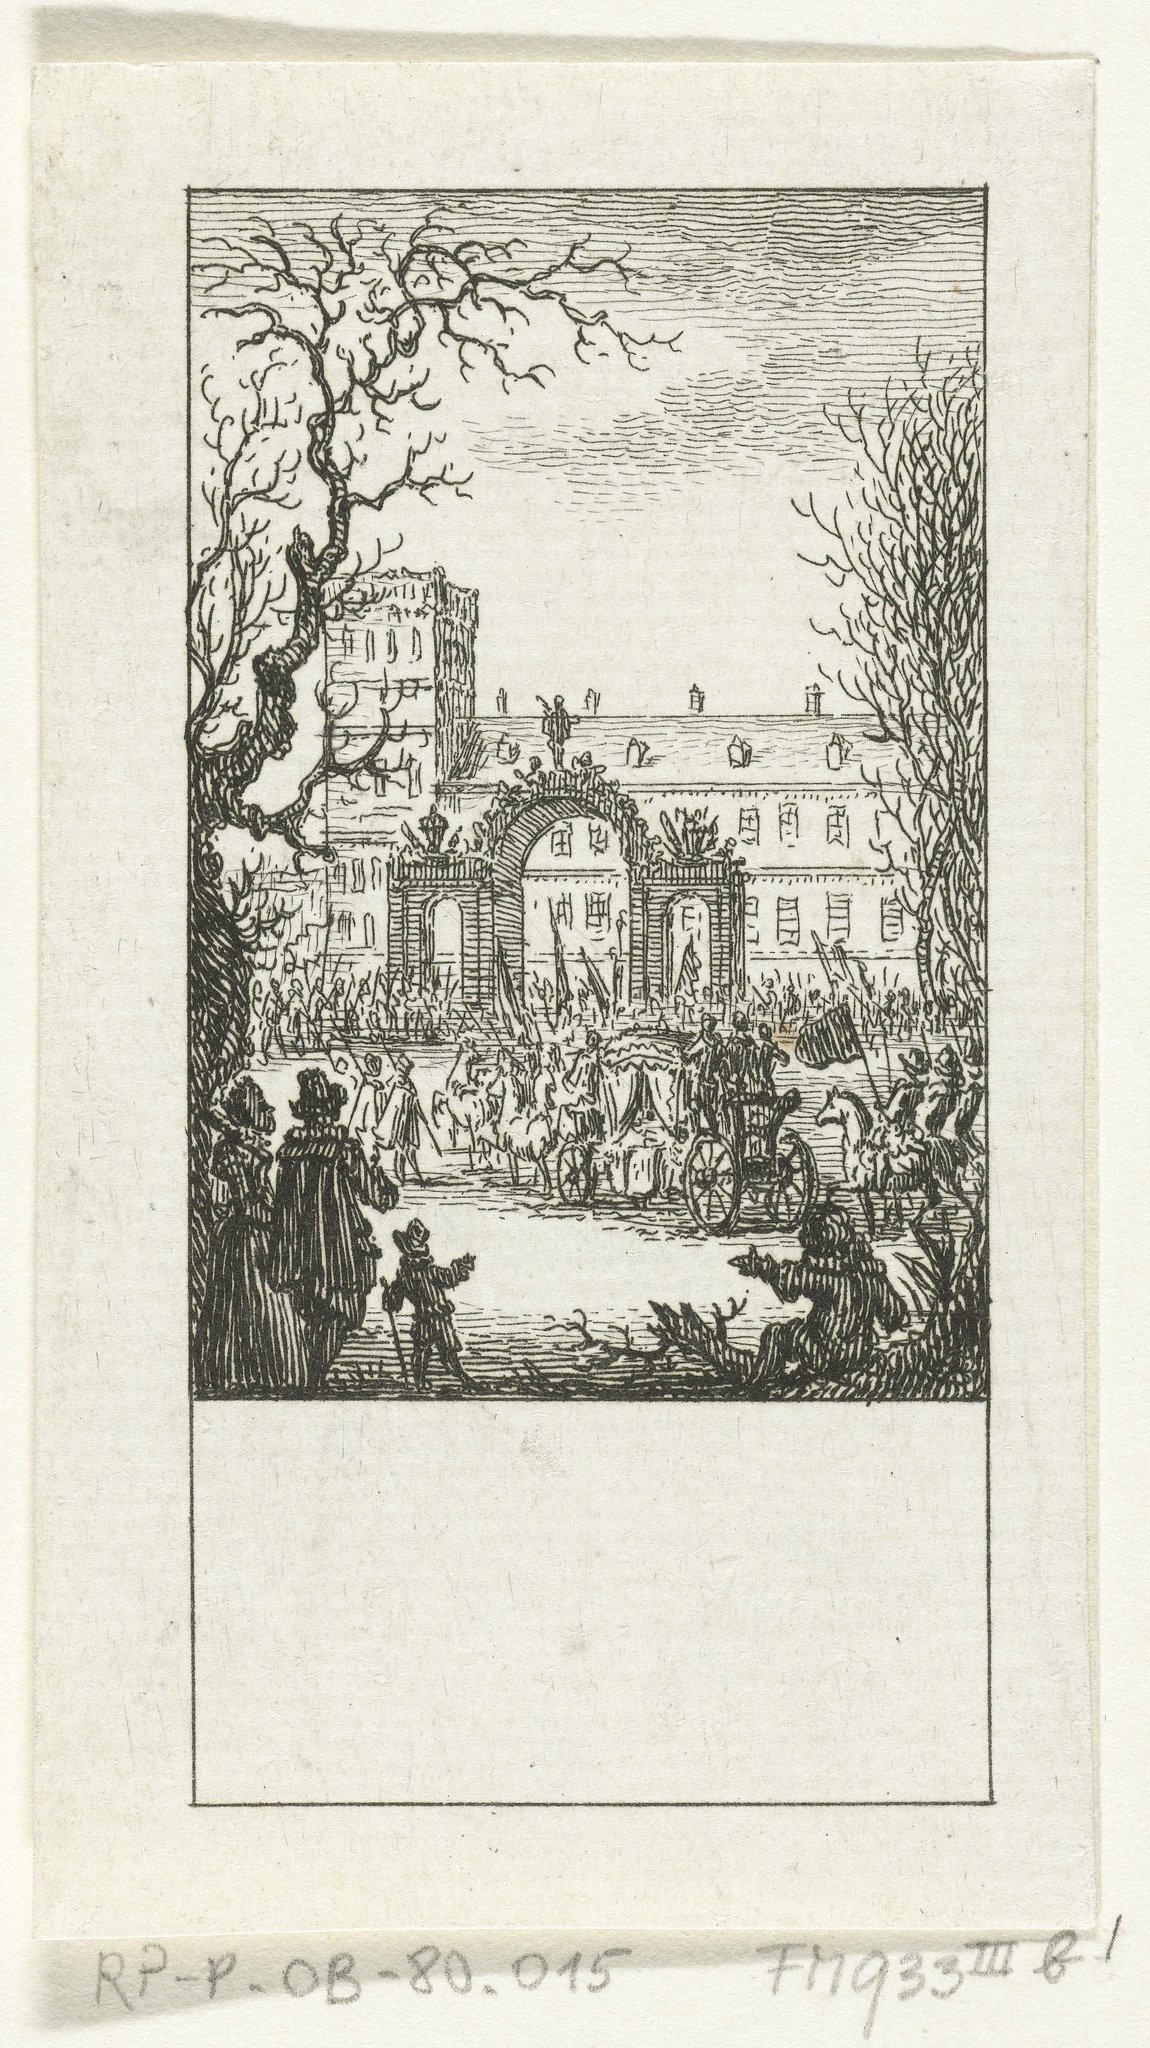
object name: history print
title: De aankomst van de graaf van Leicester te 's-Gravenhage, 1586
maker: simon fokke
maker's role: draughtsman, print maker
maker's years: 1712-1784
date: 1722-1784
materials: paper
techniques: etching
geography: northern netherlands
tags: robert dudley (1st earl of leicester), triumphal entry and public reception, pageant, 'entrée solennelle', 'joyeuse entrée', the hague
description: Aankomst van Robert Dudley, graaf van Leicester, te 's-Gravenhage op 6 januari 1586. Feestelijke ontvangst van de rijtuig met de graaf bij een triomfpoort.